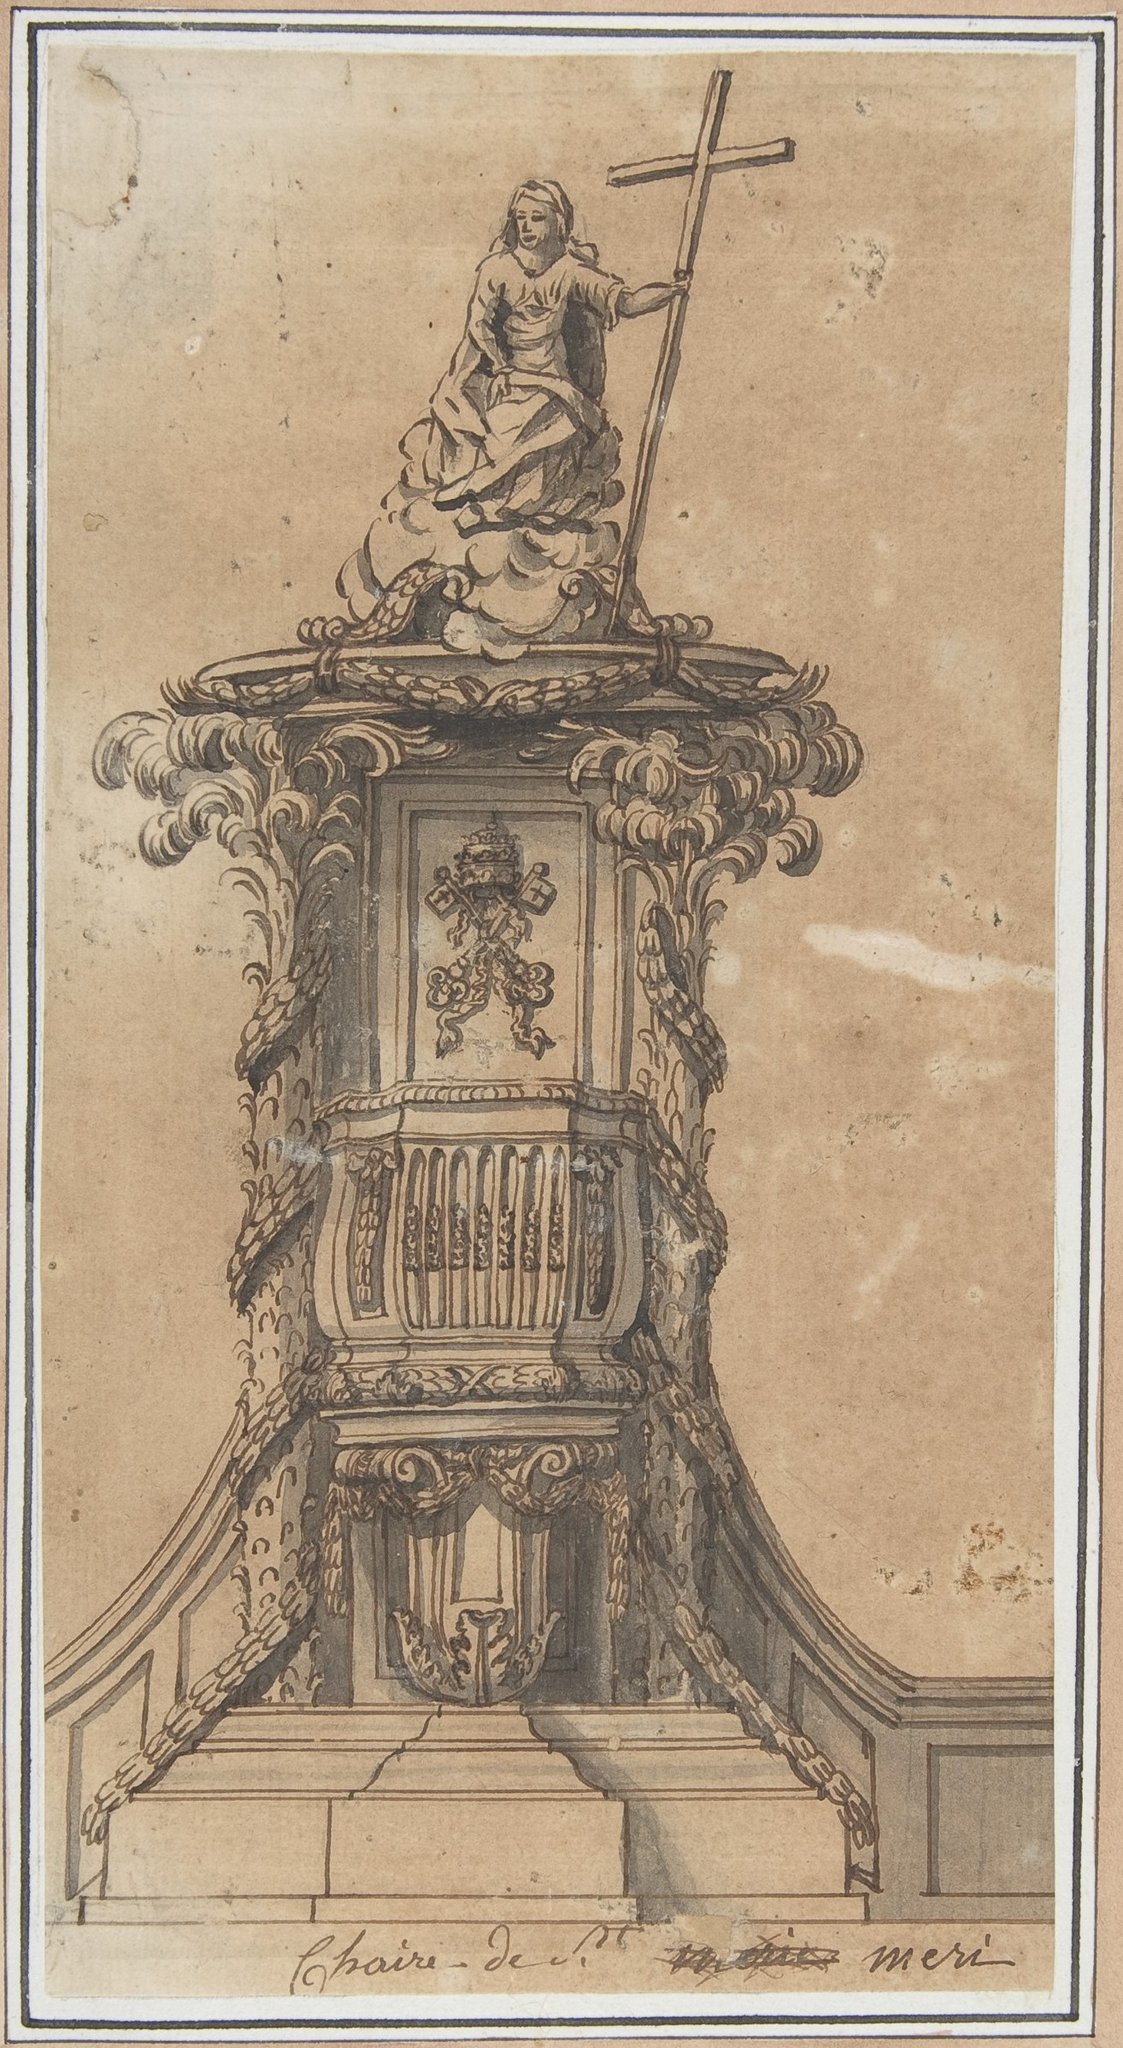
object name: drawing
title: Design for Pulpit with Papal Tiara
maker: anonymous, french, 18th century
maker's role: artist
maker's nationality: french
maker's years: 1700-1800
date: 1701-1800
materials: chalk, ink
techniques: brush, pen, wash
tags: architecture